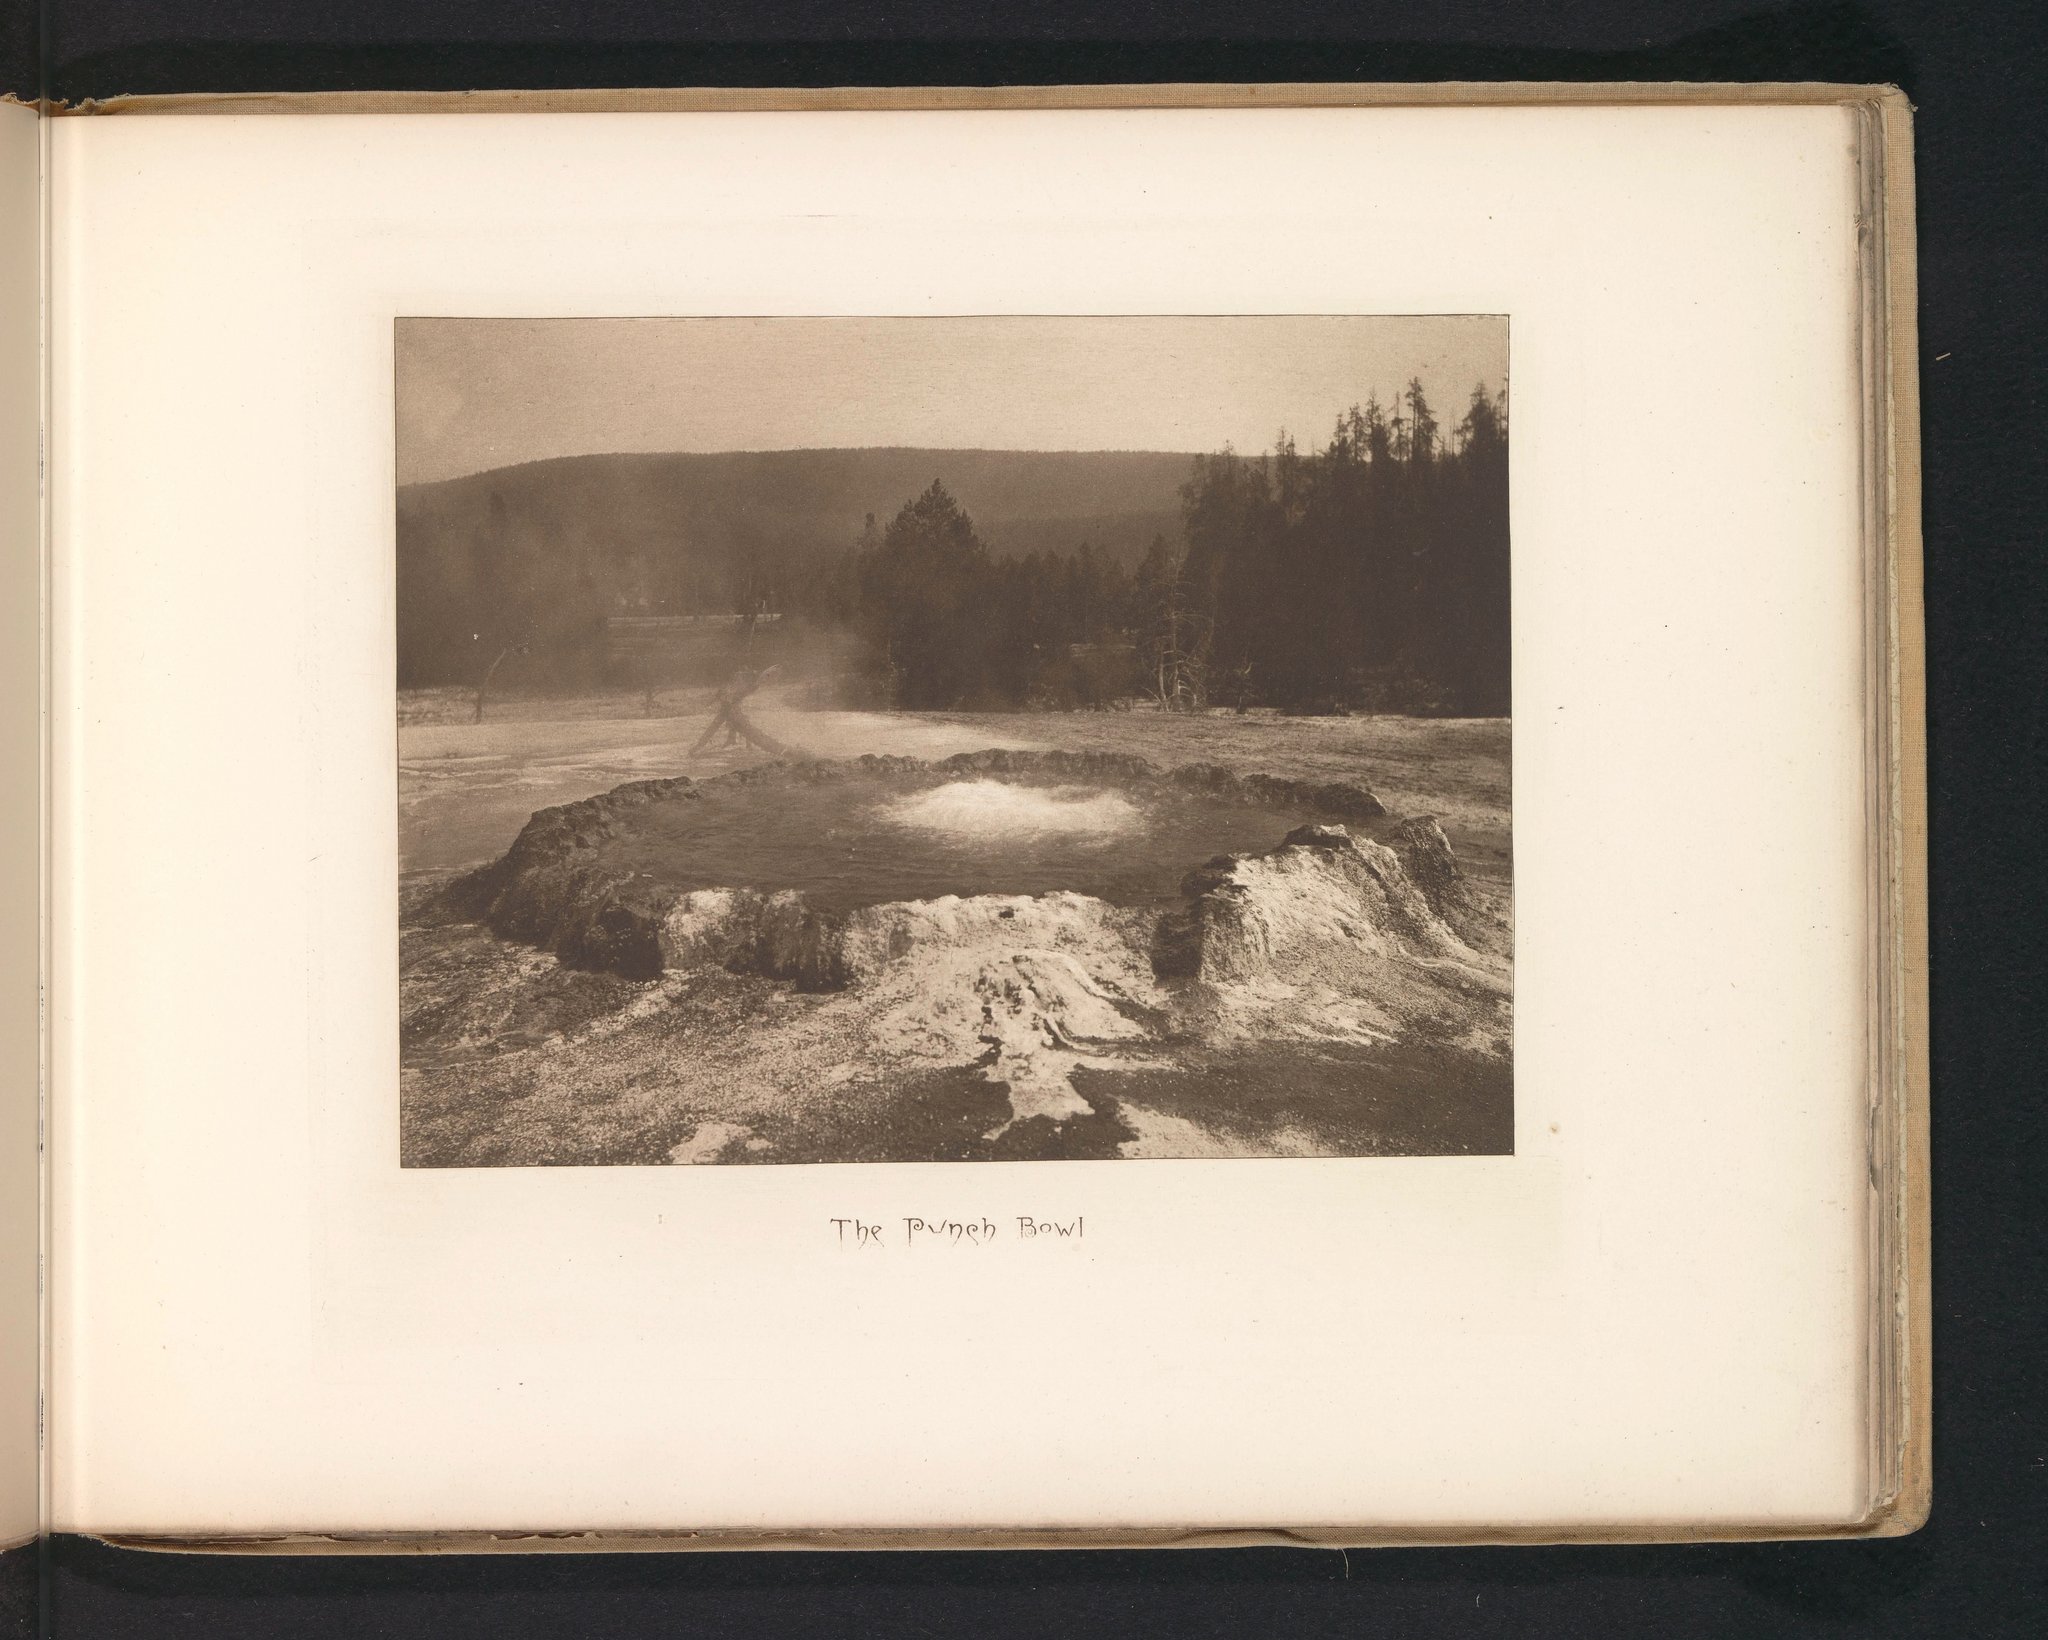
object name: photomechanical print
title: The Punch Bowl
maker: frank jay haynes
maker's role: fotograaf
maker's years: 1853-1921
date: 1882-1887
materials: paper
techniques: photoaquatint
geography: new york city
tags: hot spring, geyser